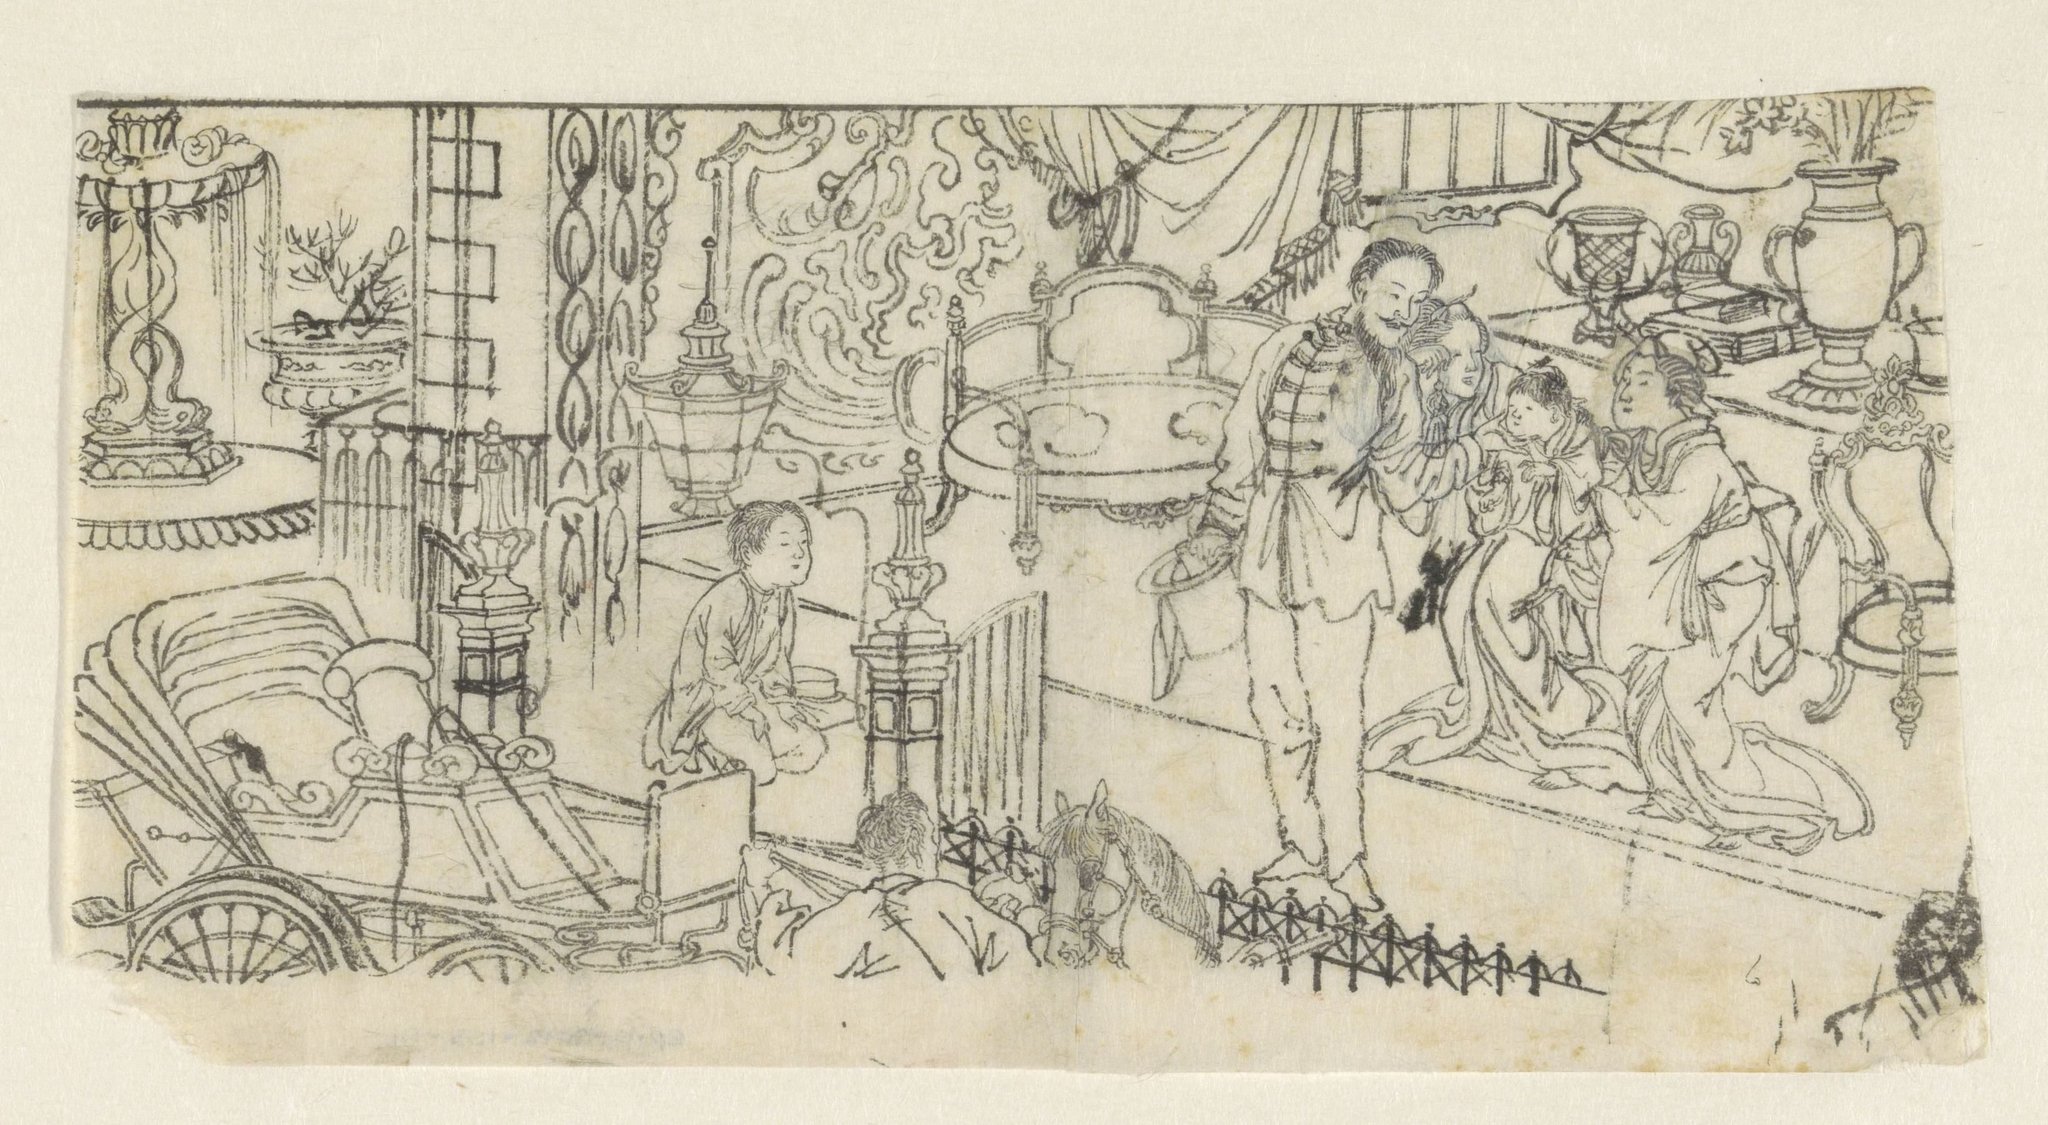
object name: drawing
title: Man zegt kind gedag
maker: kawanabe kyôsai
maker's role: draughtsman, print maker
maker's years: 1831-1889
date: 1870-1880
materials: paper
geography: japan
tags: family life at home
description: Een man zegt gedag tegen een vrouw en kind, in een Japans huis met westers interieur. Buiten staat een rijtuig klaar.